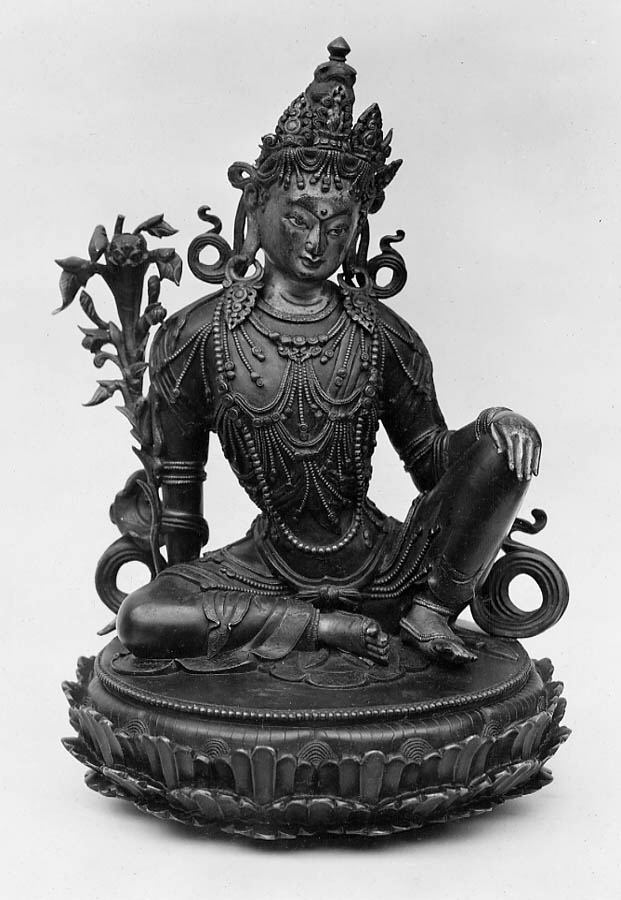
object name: figure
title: Seated Avalokiteshvara (The Bodhisattva of Infinite Compassion)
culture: tibetan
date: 1601-1800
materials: bronze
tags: buddhism,avalokiteshvara,bodhisattvas